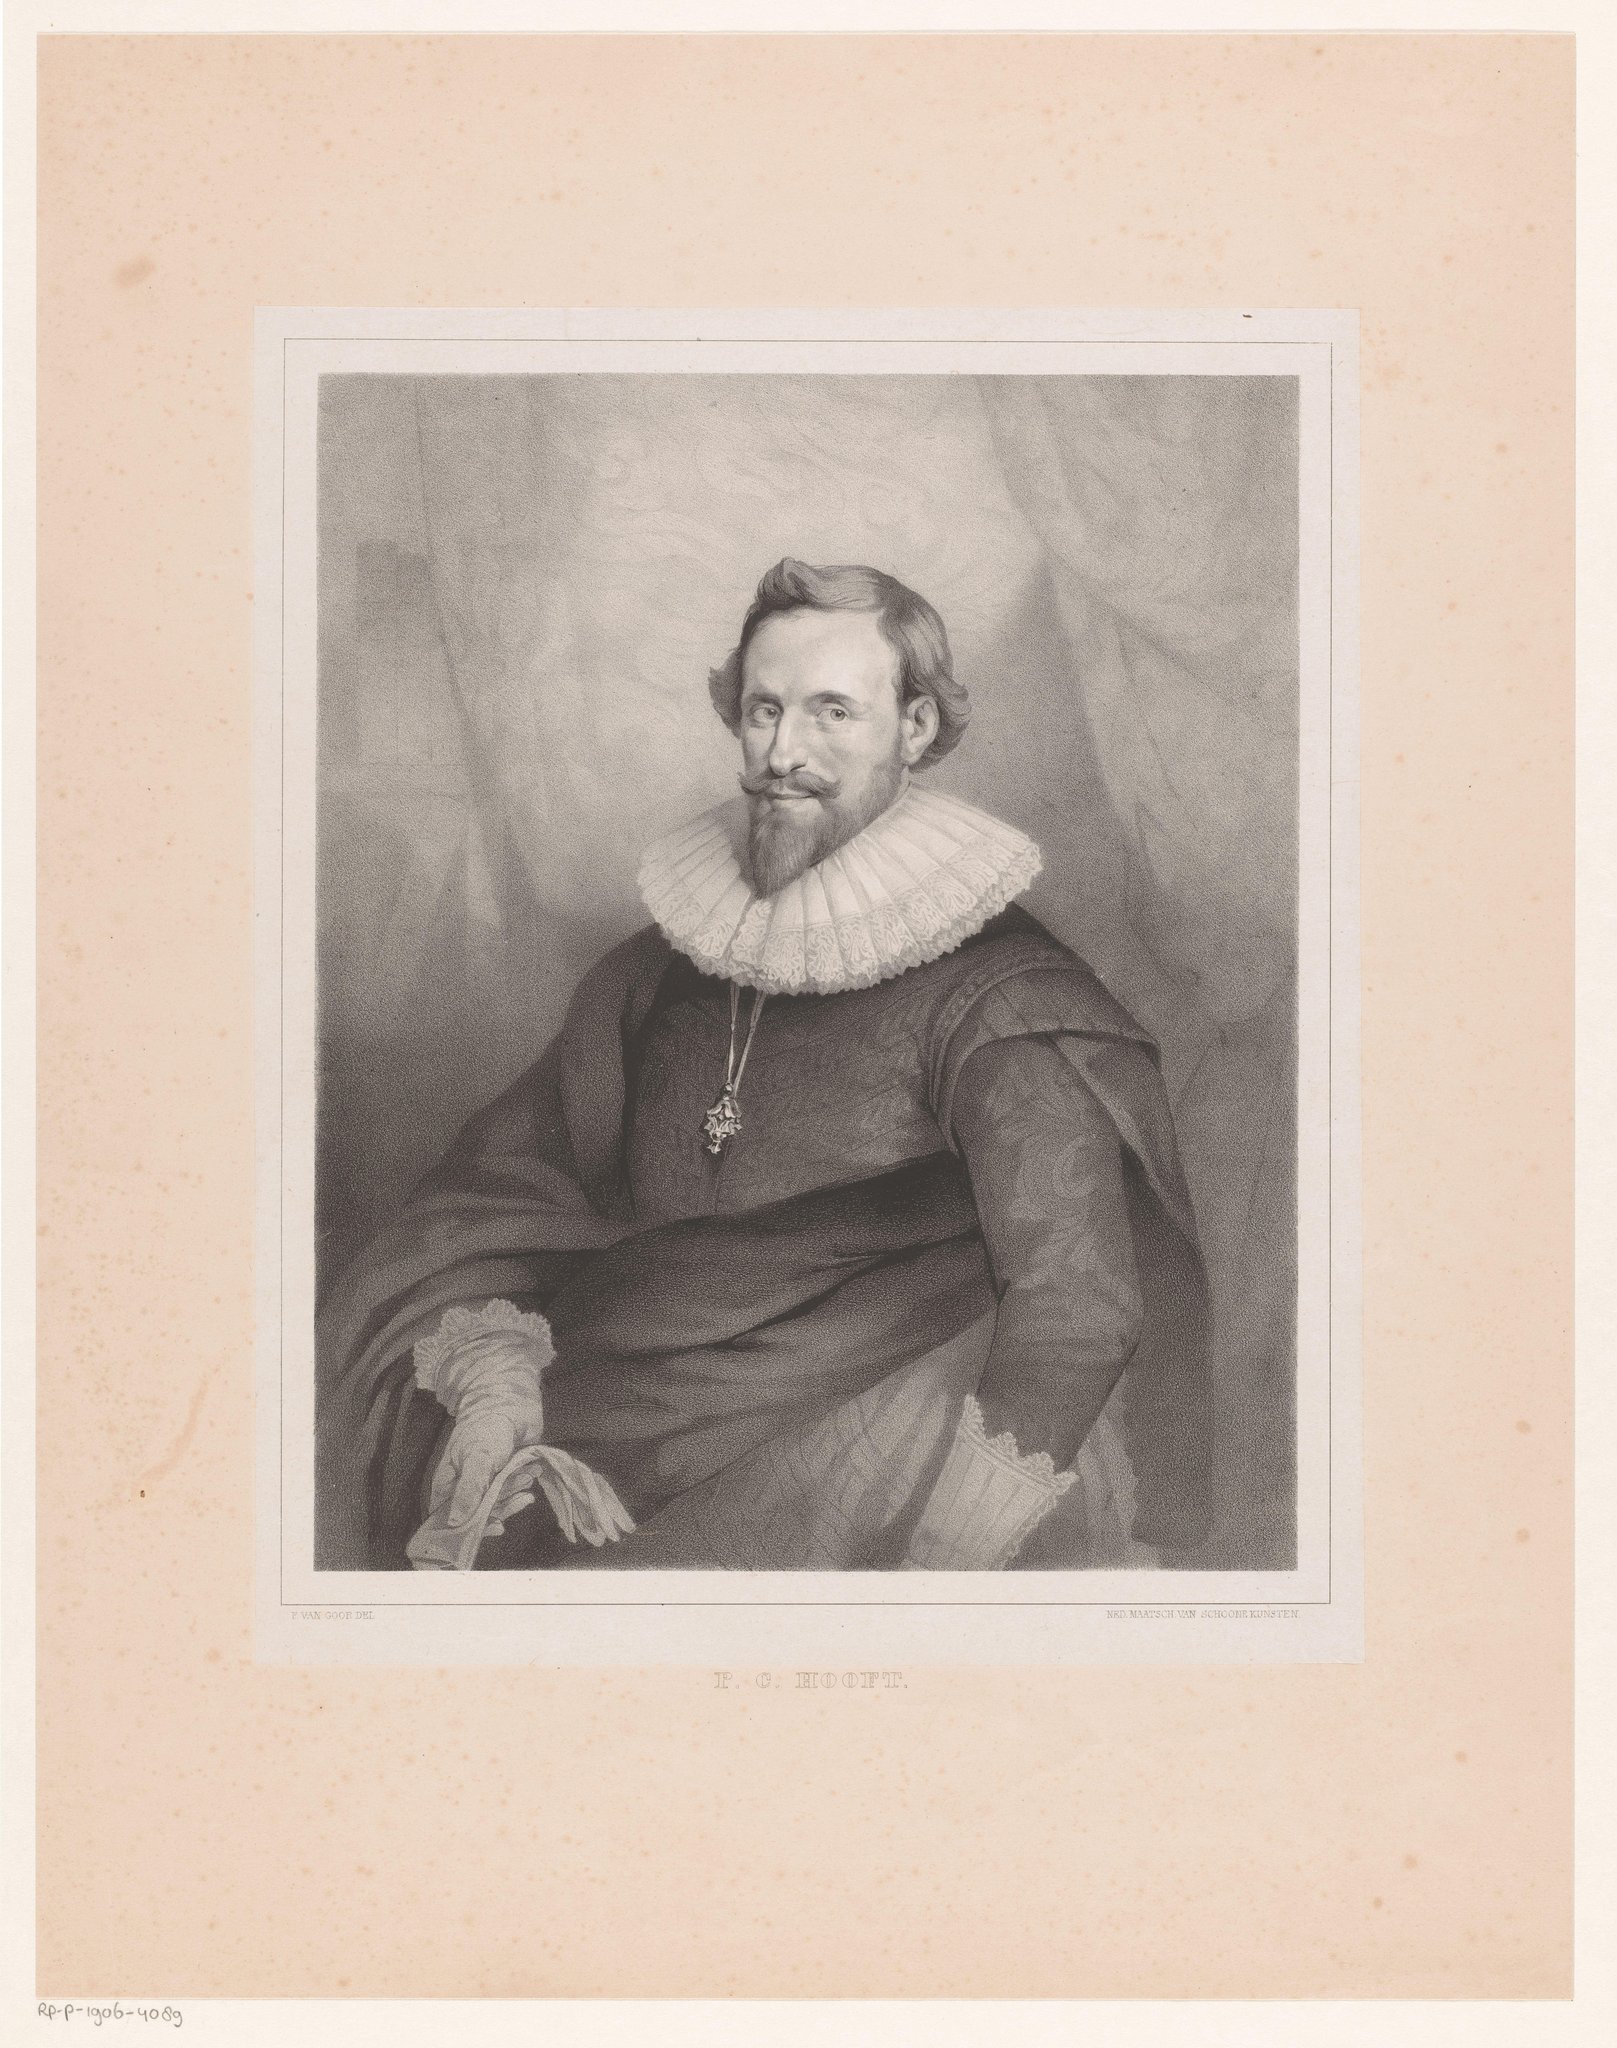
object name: print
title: Portret van Pieter Corneliszoon Hooft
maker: f. van goor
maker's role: print maker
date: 1840-1843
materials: paper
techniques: lithograph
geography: the hague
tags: amsterdam, mayor, cornelis pietersz. hooft, pendant, trinket, 'breloque', historical persons (+ half-length portrait)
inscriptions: collector's mark: Lugt 2228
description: De geportretteerde draagt een witte kanten kraag, witte handschoenen en een ketting met een hanger.